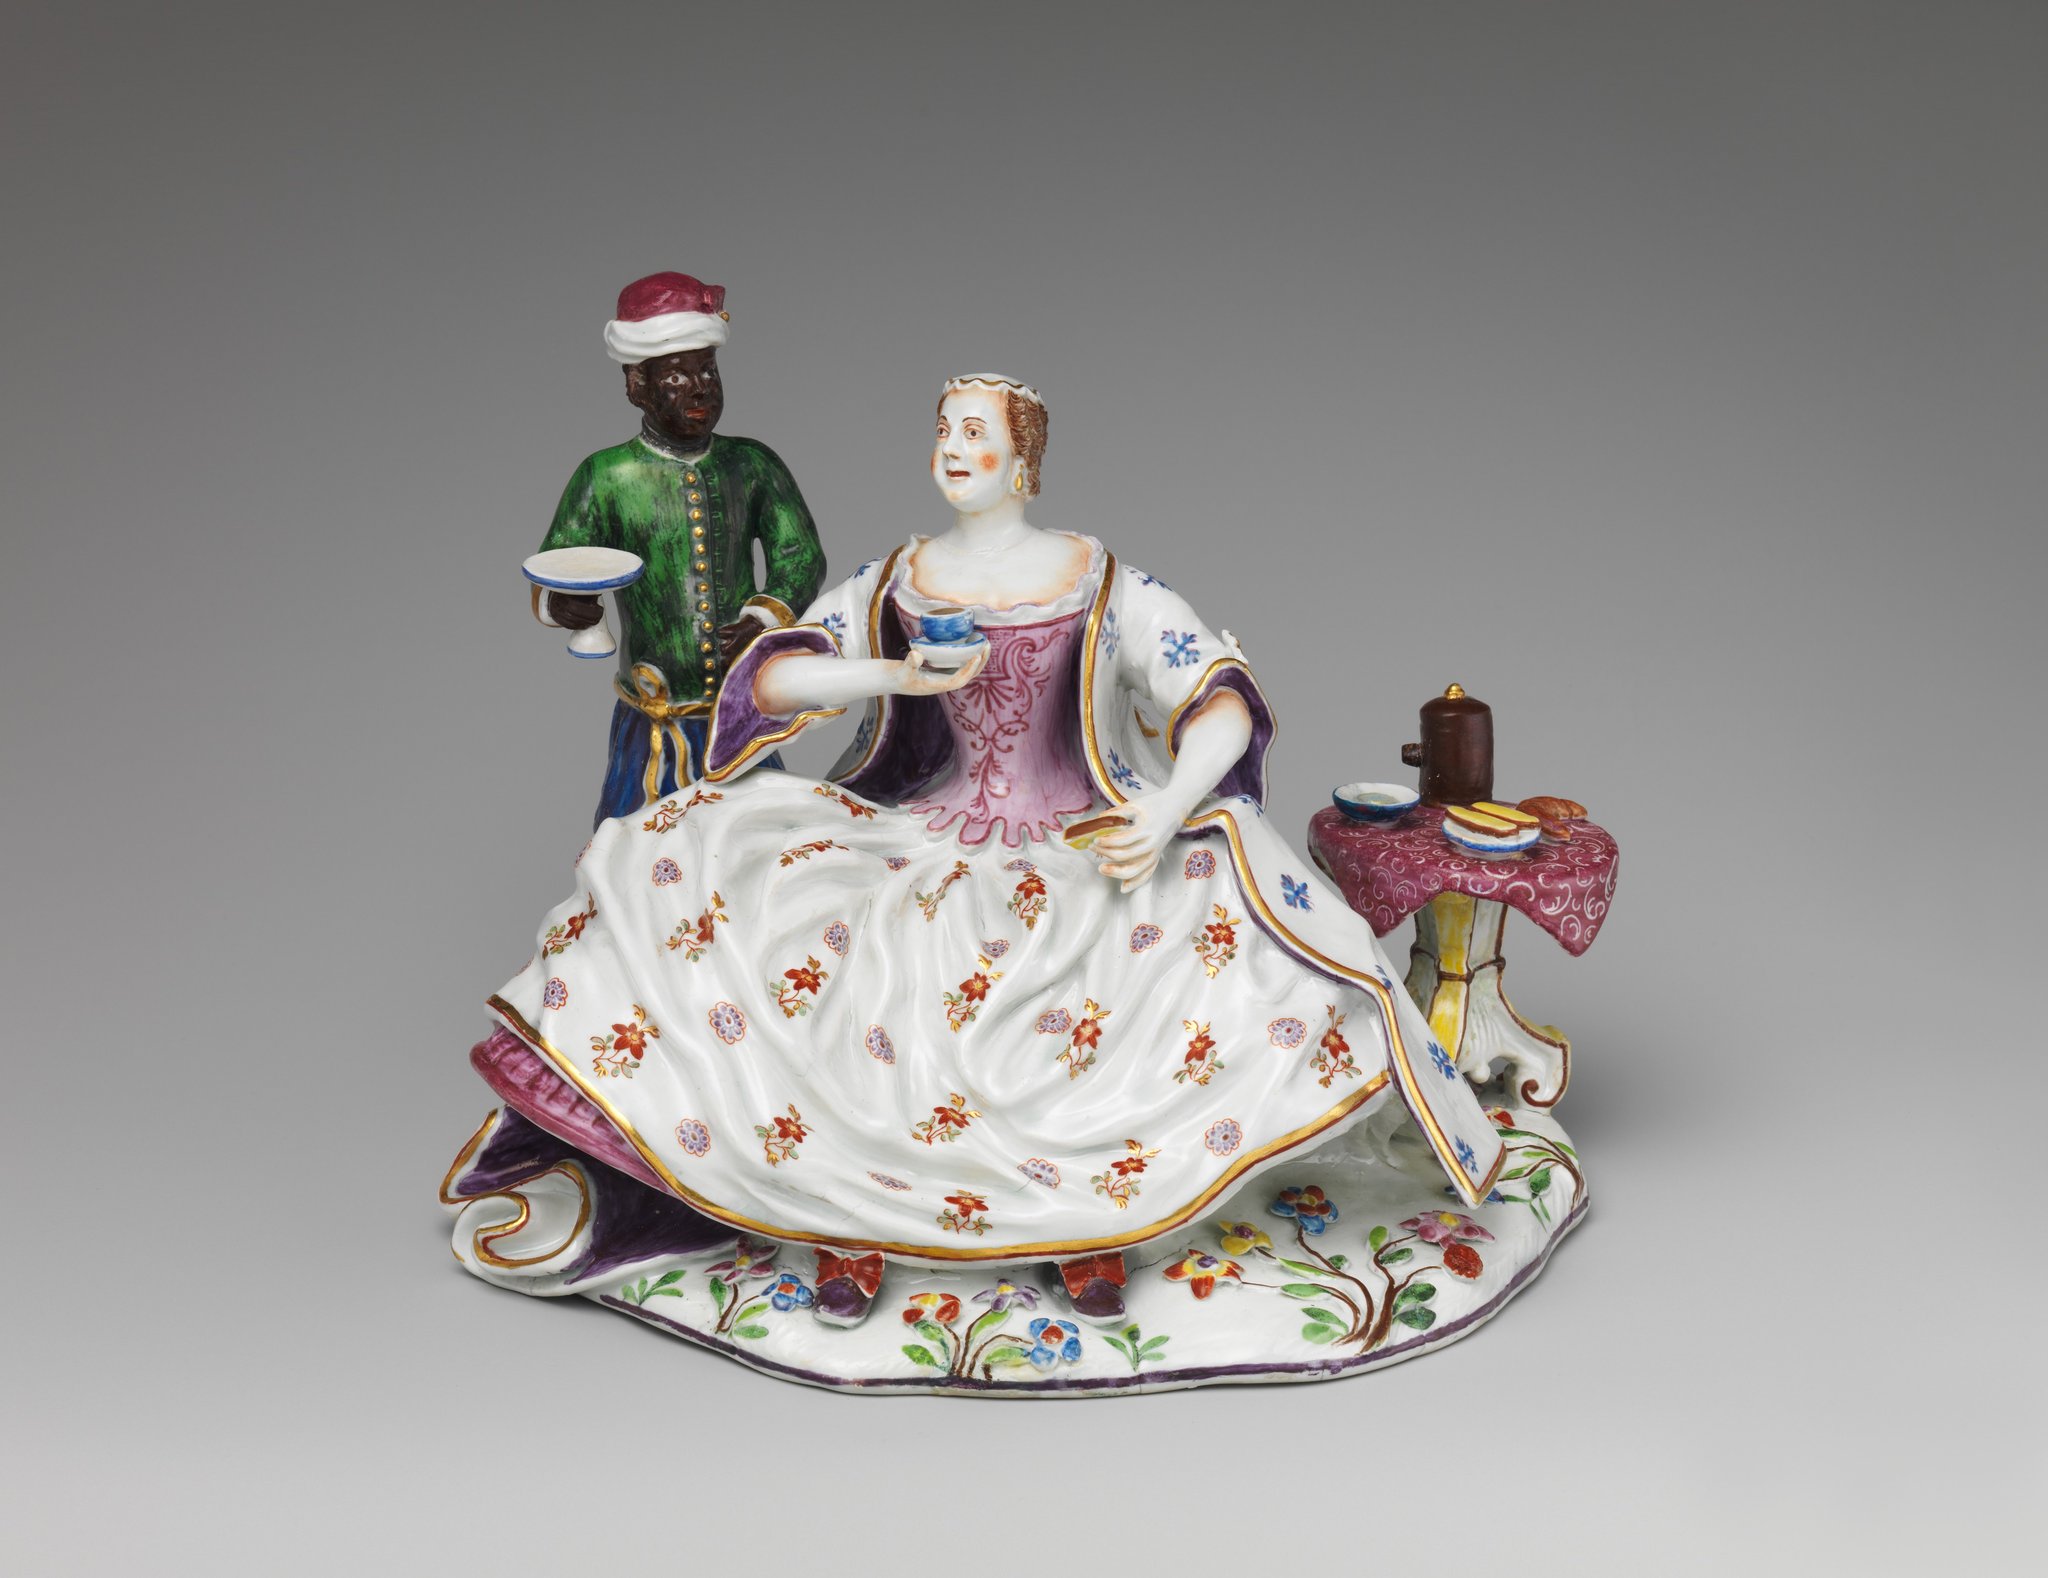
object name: group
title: Lady at her Breakfast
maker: vienna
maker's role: manufactory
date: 1737-1744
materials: hard paste porcelain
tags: food,men,women,drinking,servants